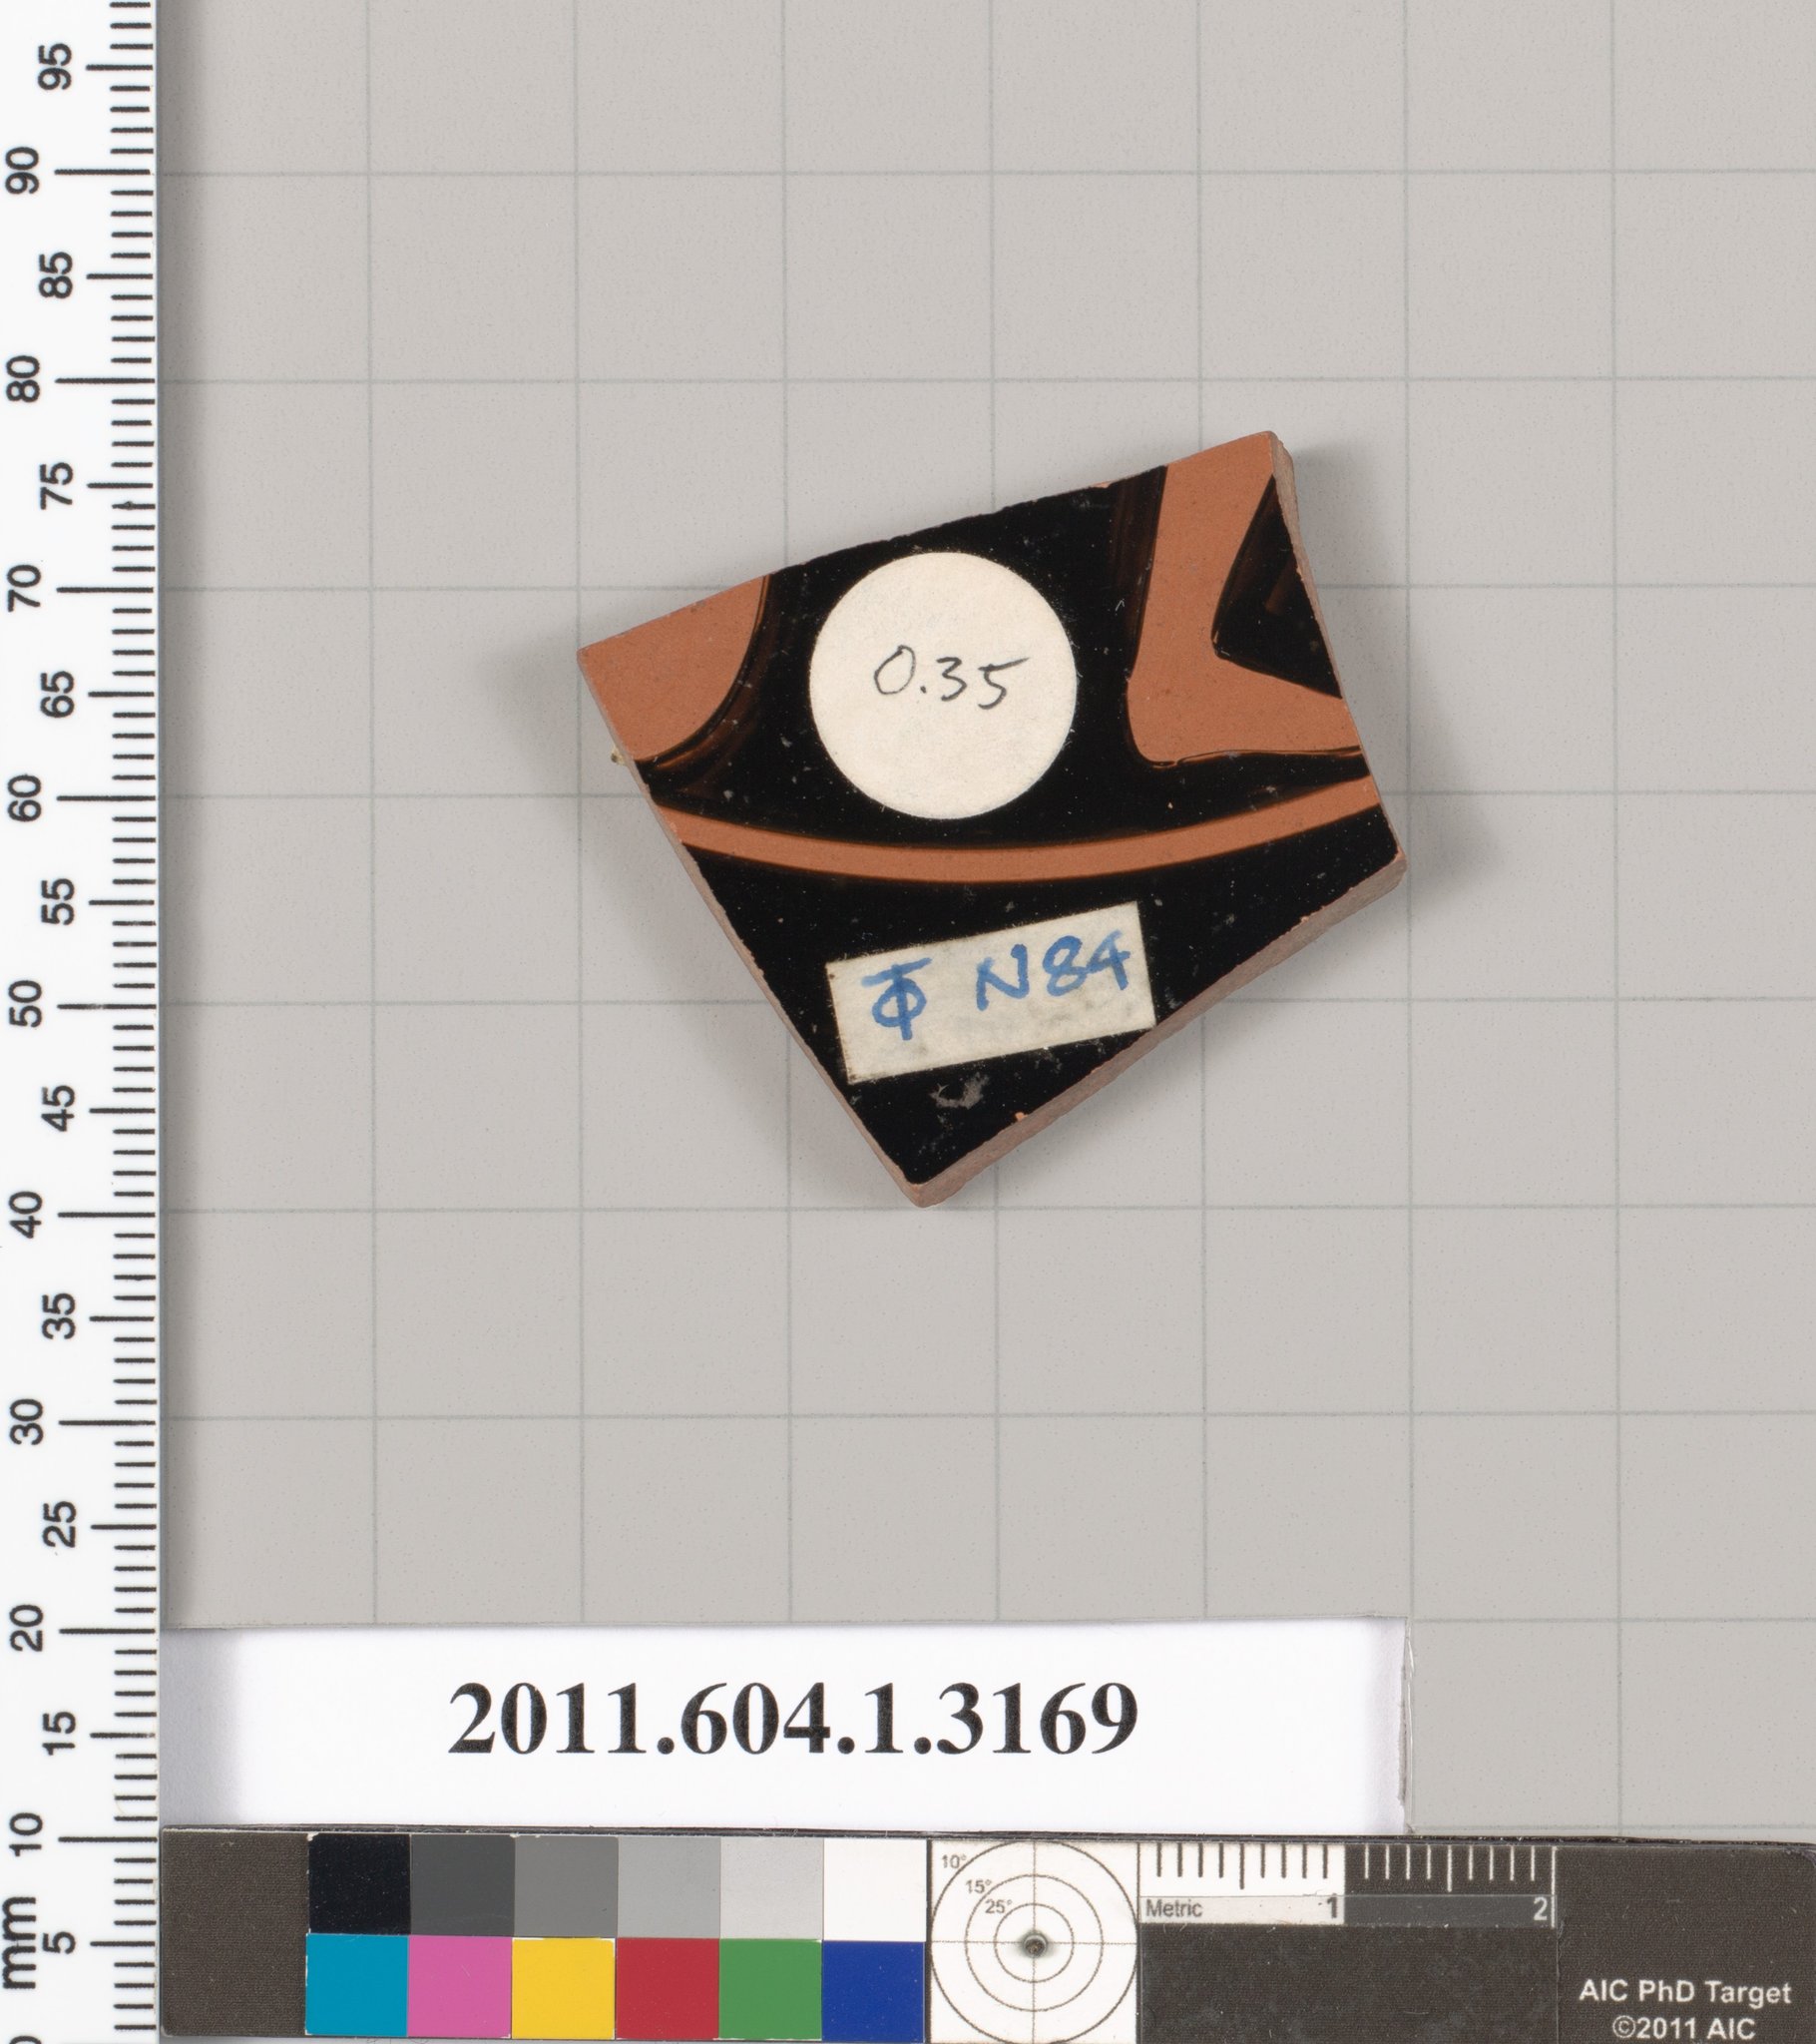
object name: kylix fragment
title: Terracotta fragment of a kylix (drinking cup)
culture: greek, attic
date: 510-490 BCE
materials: terracotta